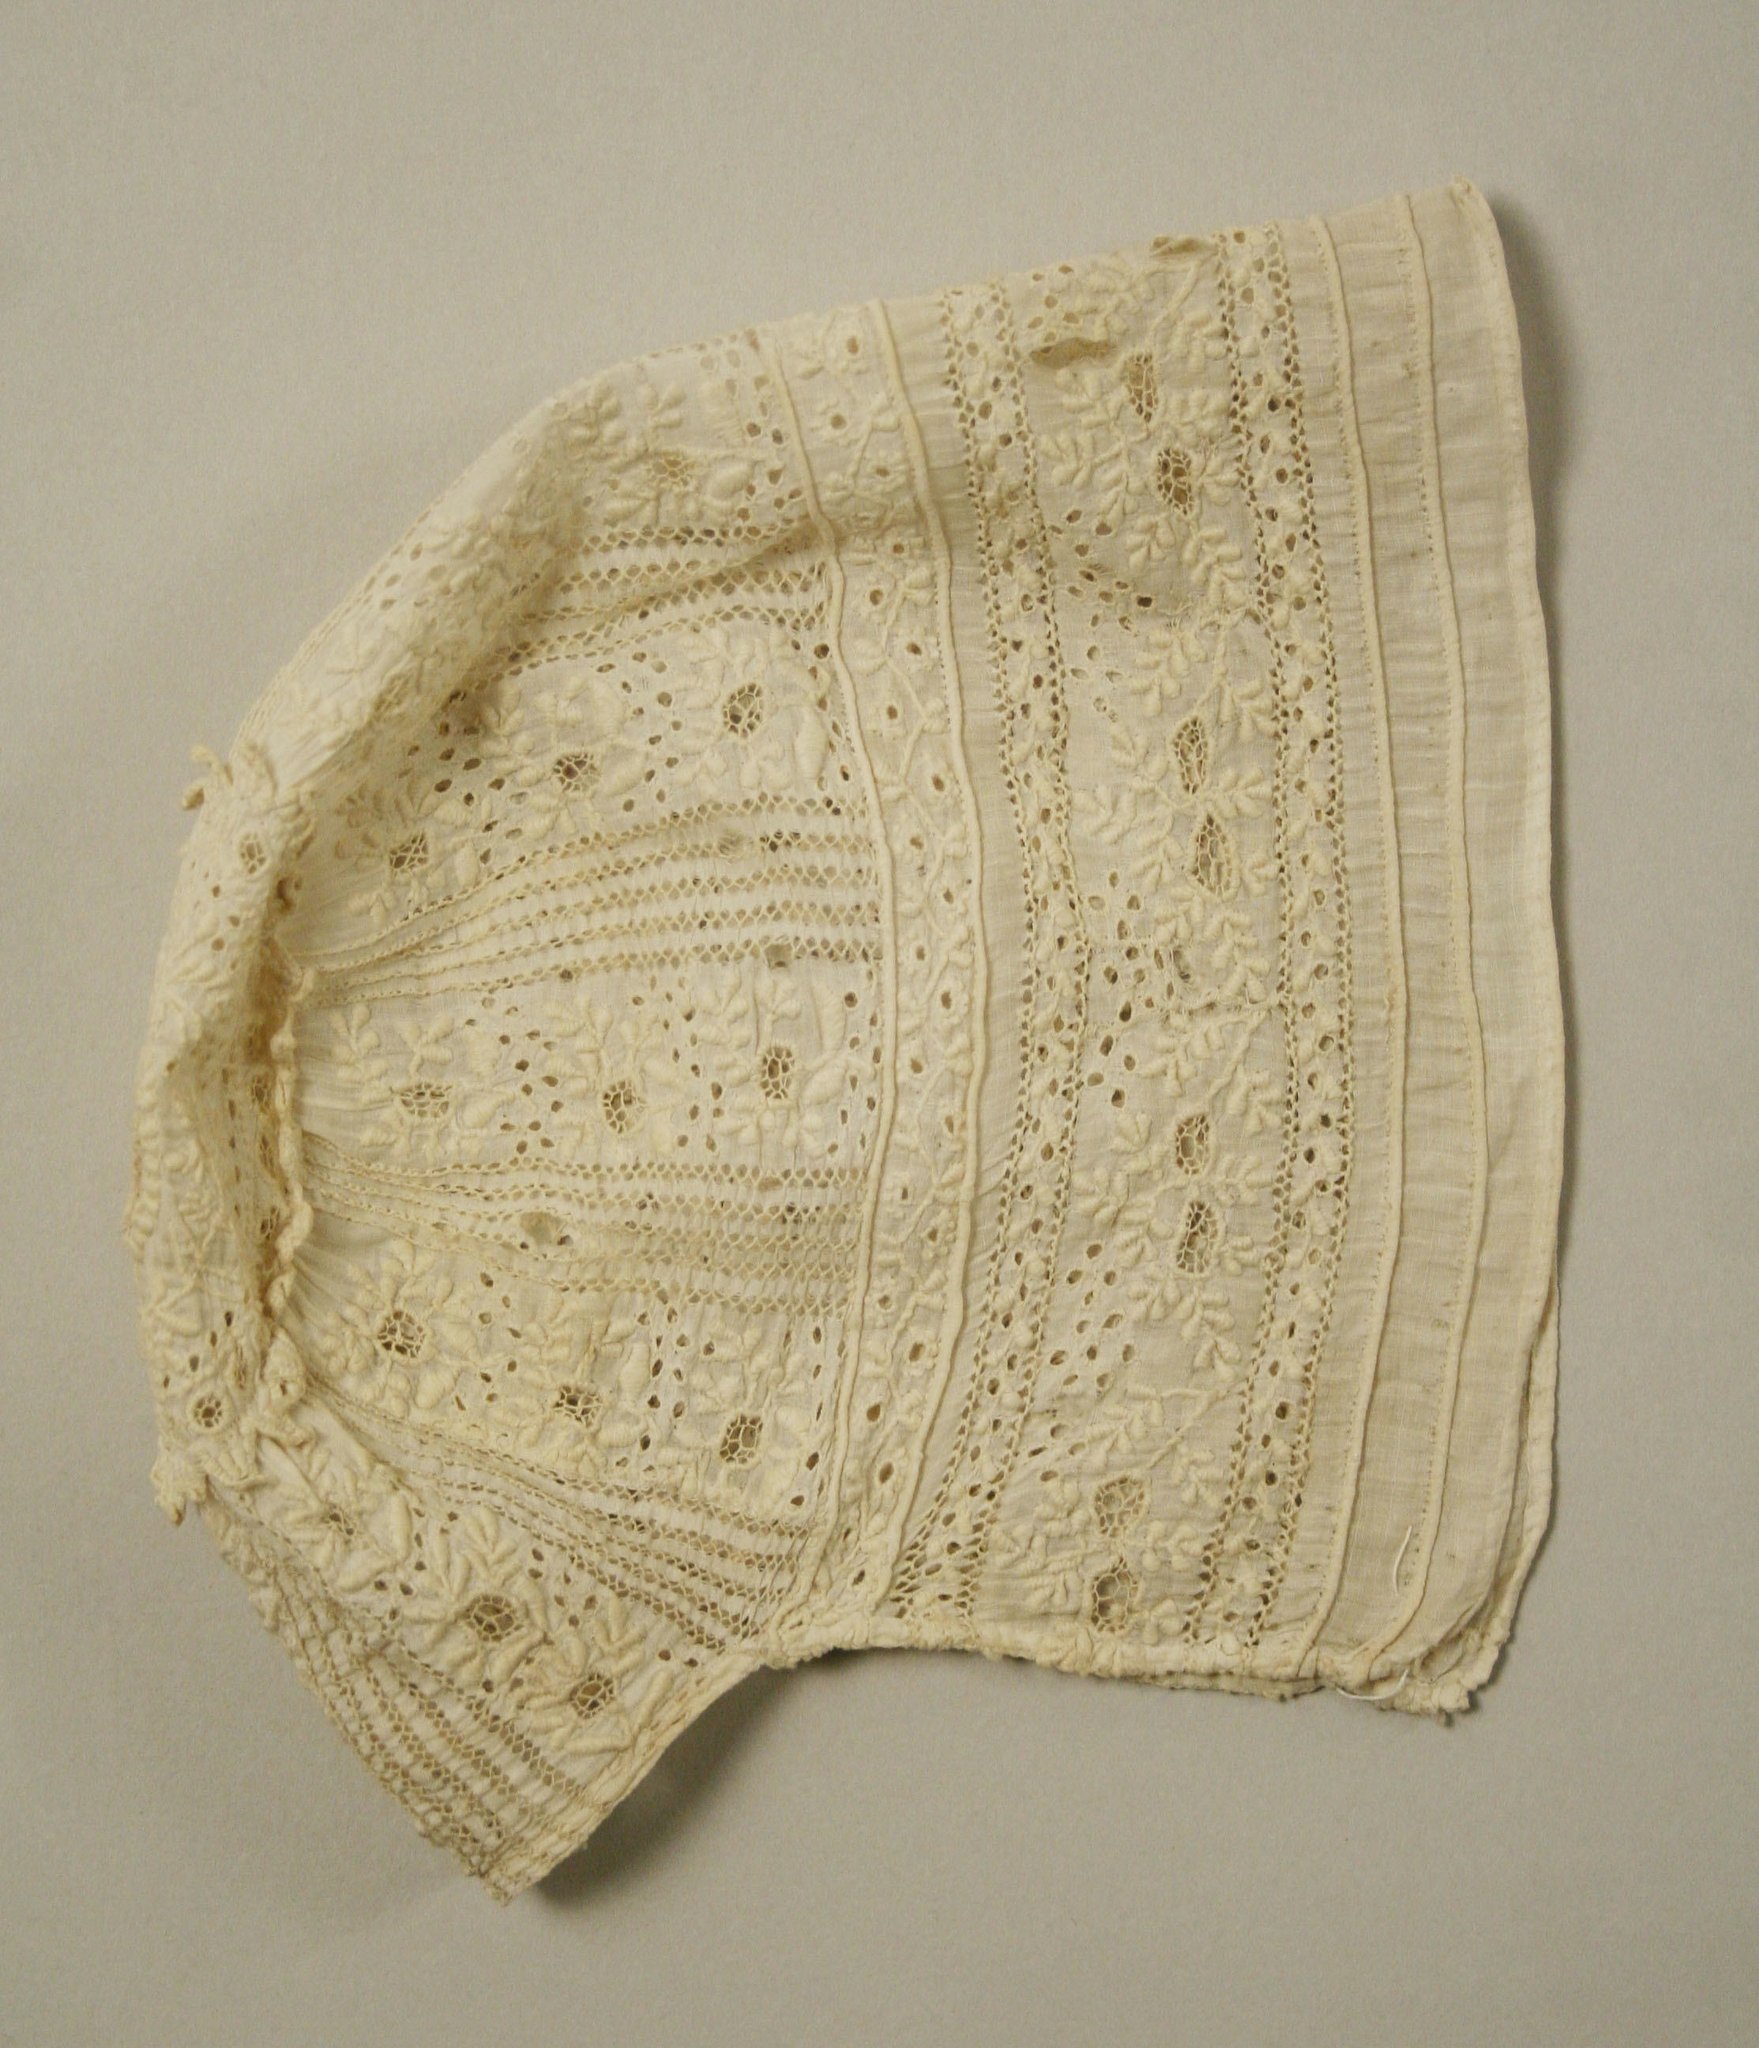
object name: cap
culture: british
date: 1801-1900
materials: linen